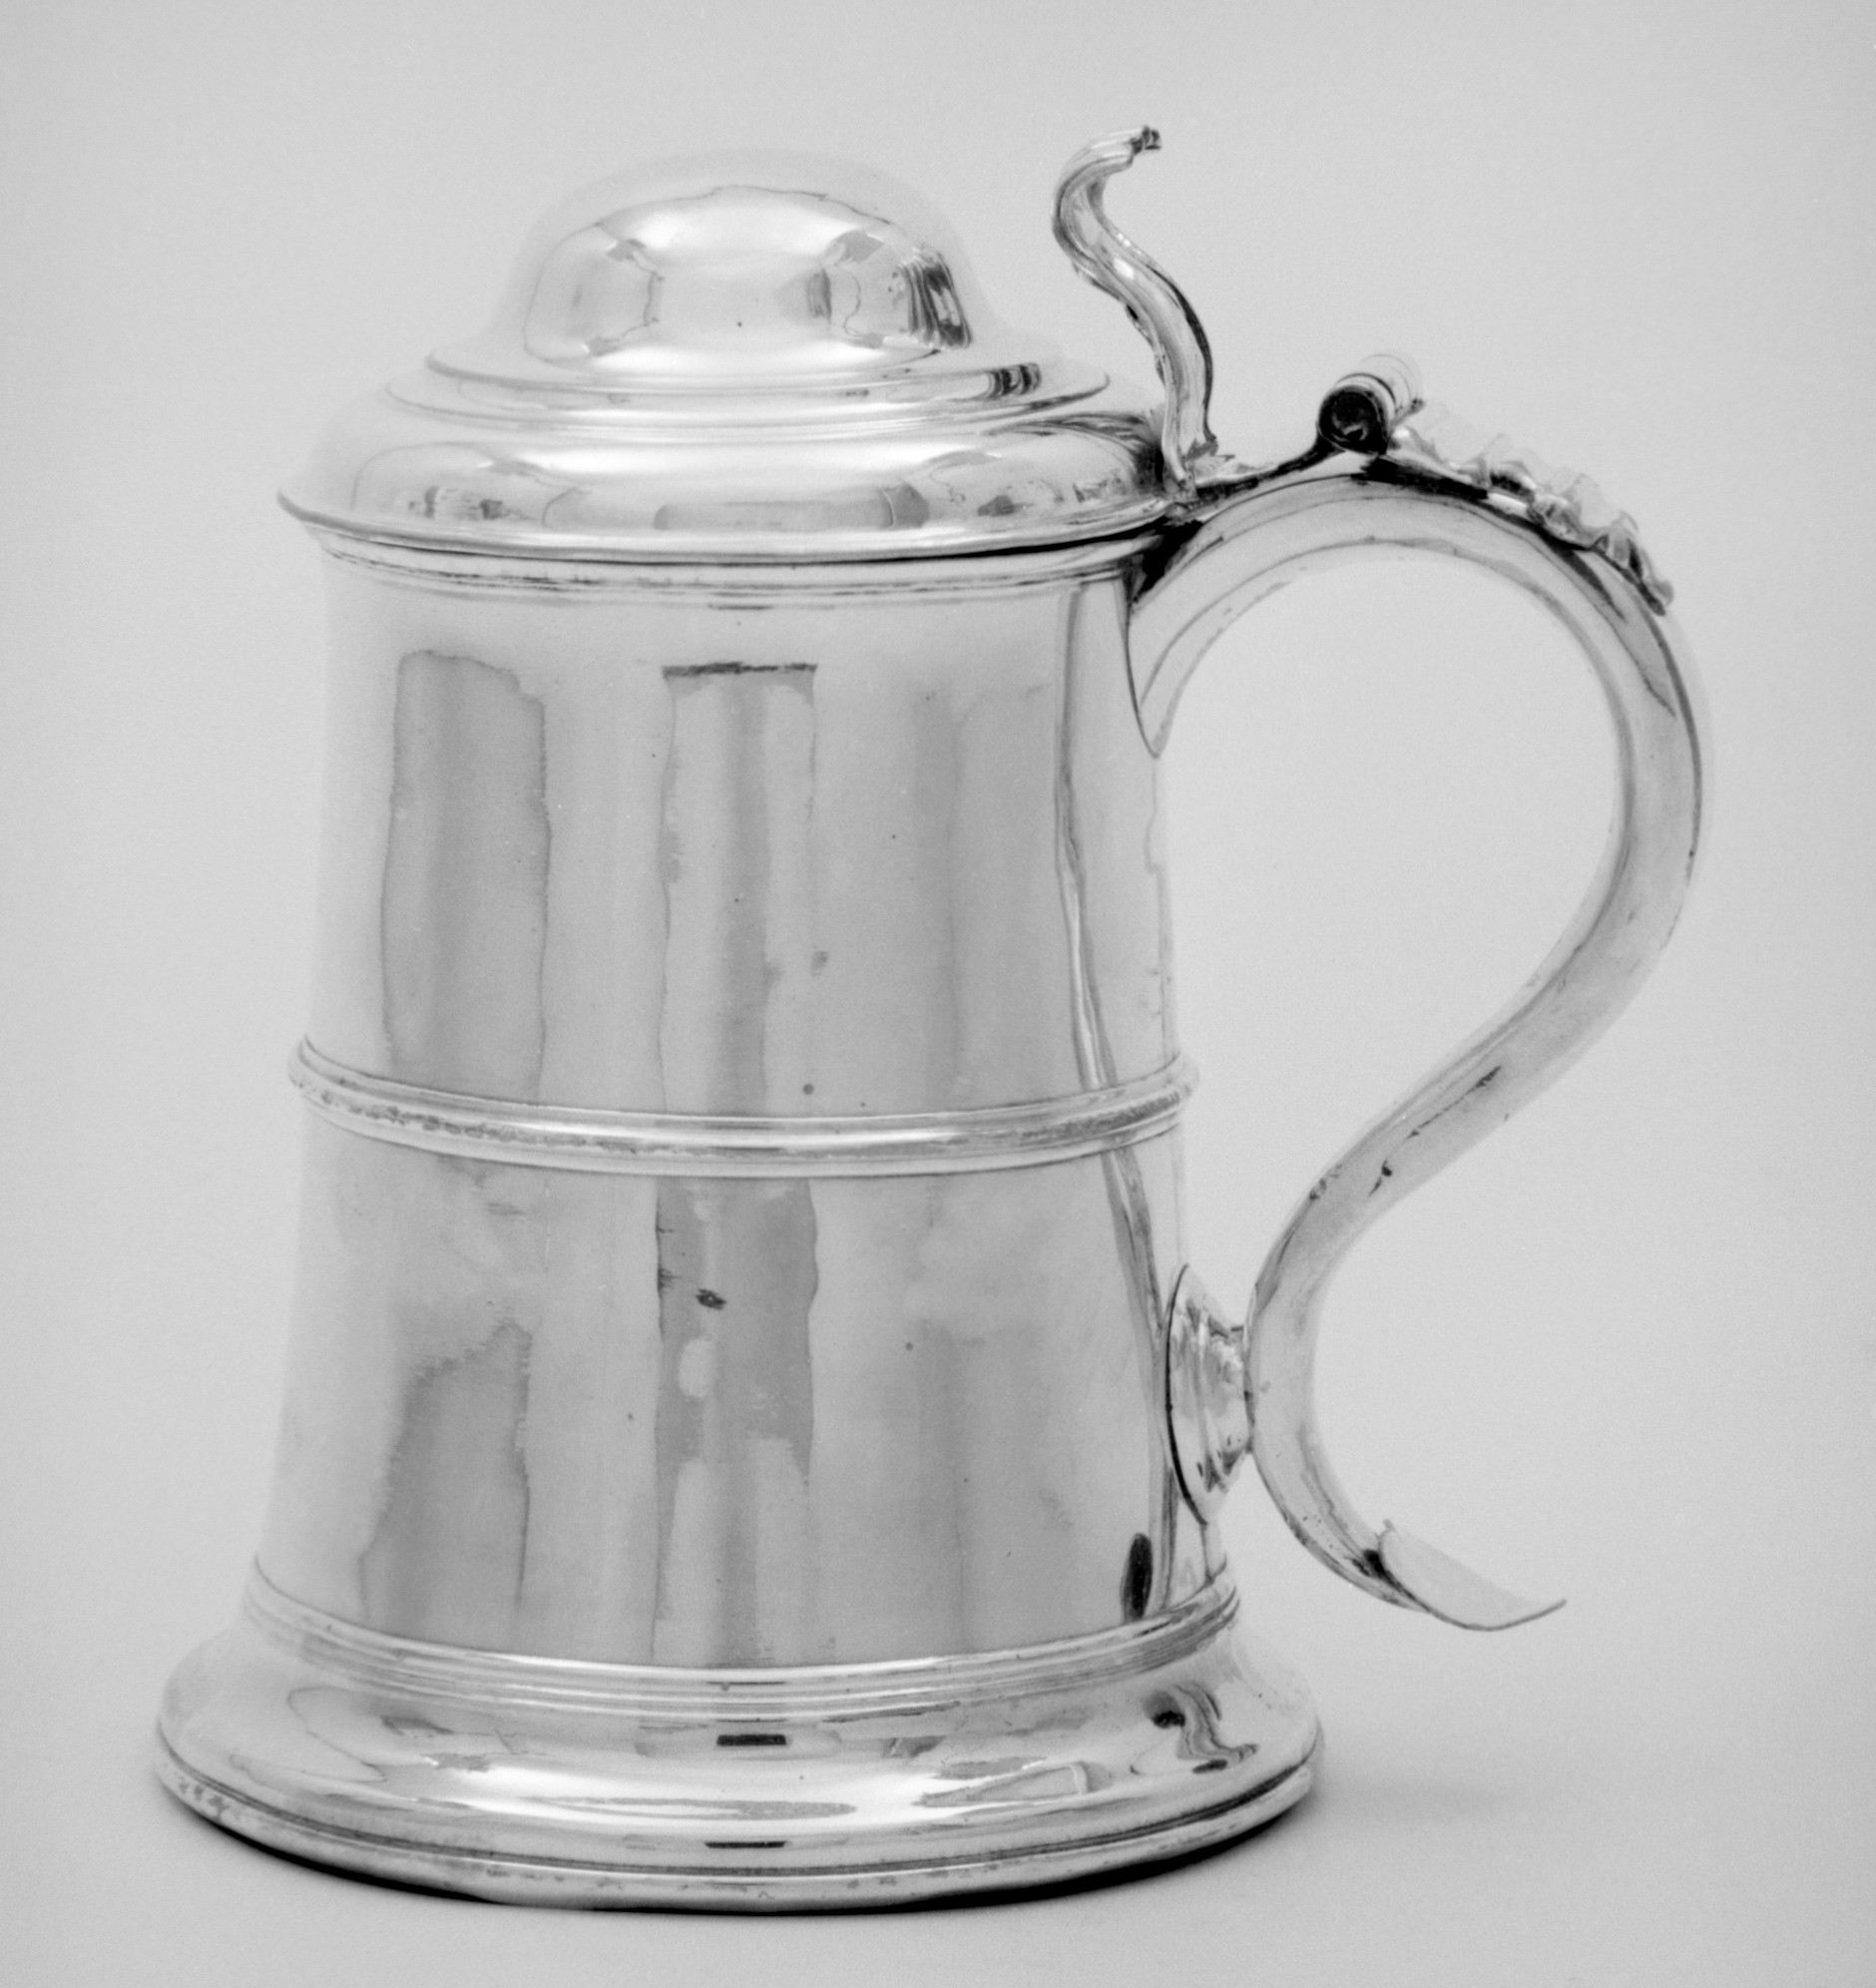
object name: tankard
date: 1780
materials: metal, wood